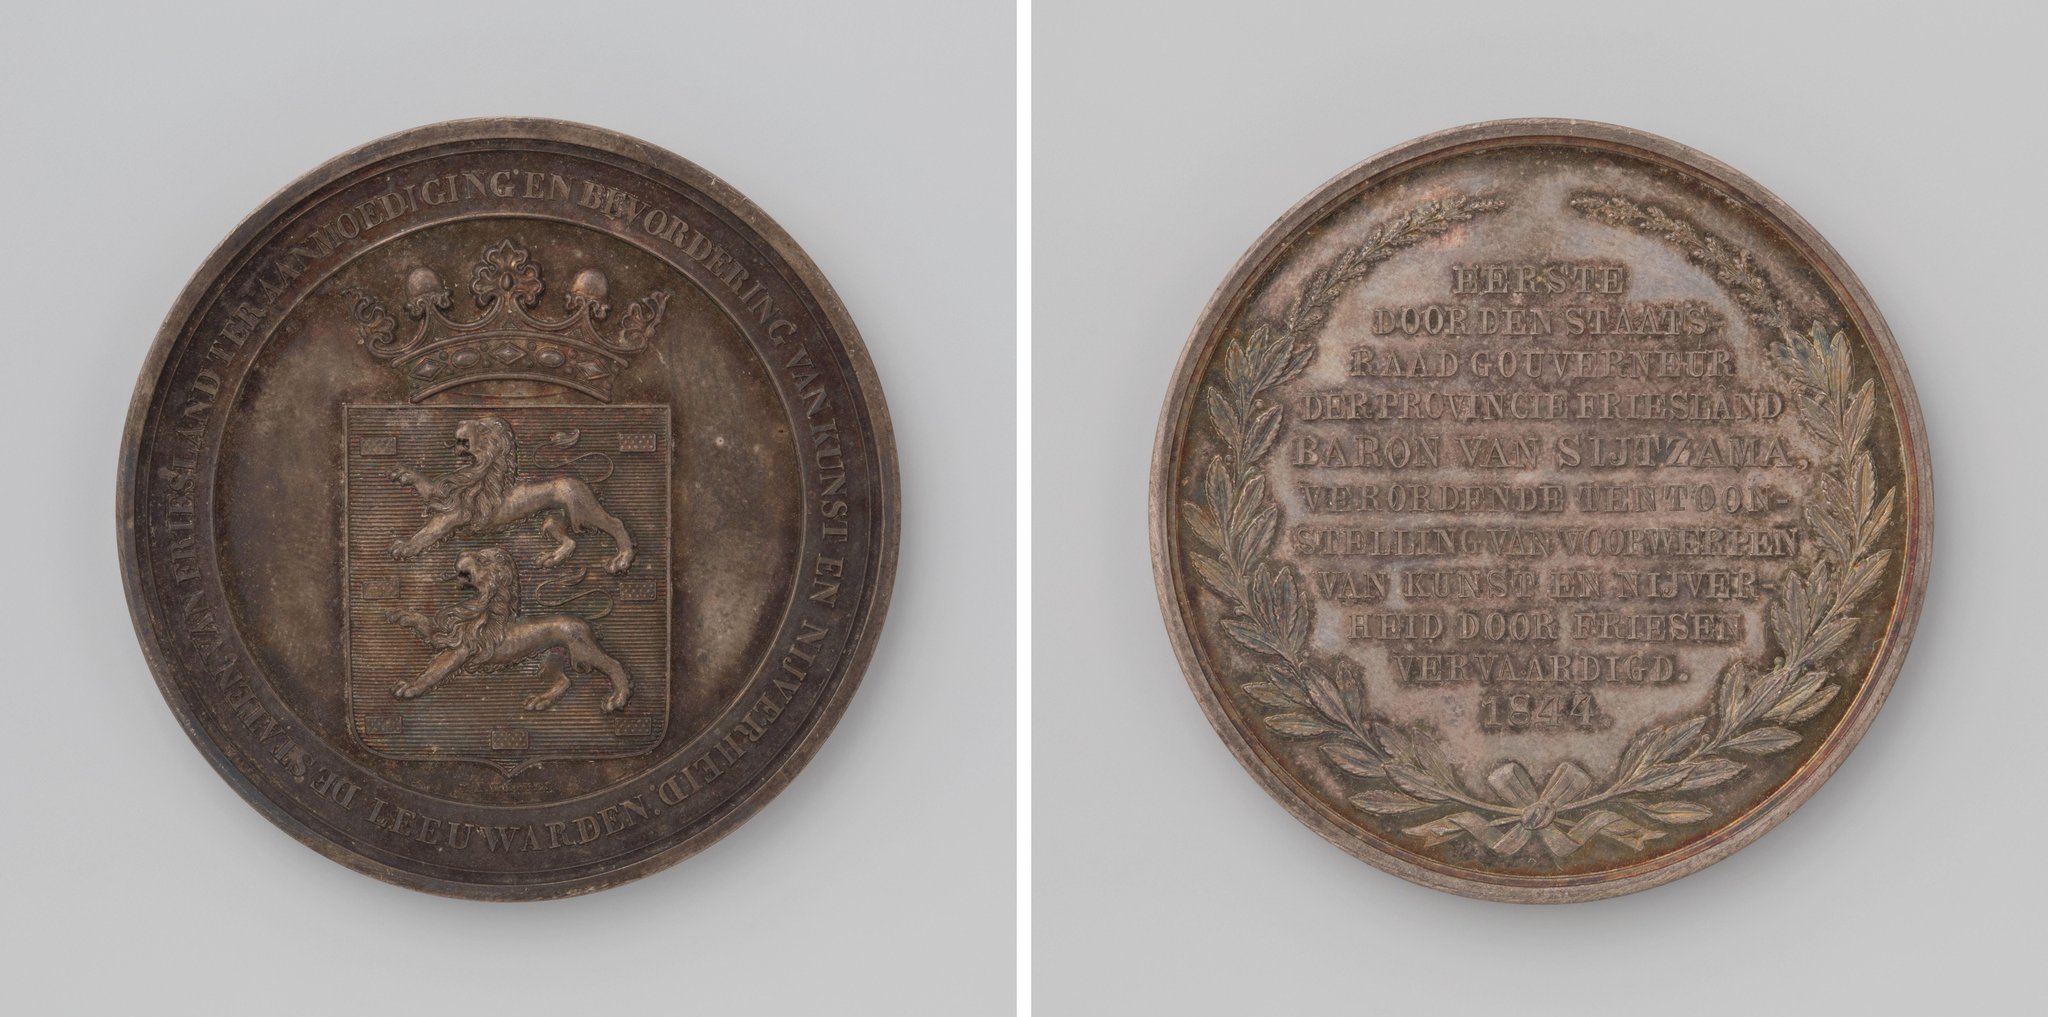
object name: medal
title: Eerste tentoonstelling van Friese kunst en nijverheid, door baron van Sytzama, staatsraad gouverneur van Friesland verordend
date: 1844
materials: silver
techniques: striking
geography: leeuwarden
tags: maurits pico diederik baron van sytzama, friesland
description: Zilveren penning. Voorzijde: gekroond wapenschild binnen omschrift. Keerzijde: opschrift binnen krans van olijftakken.